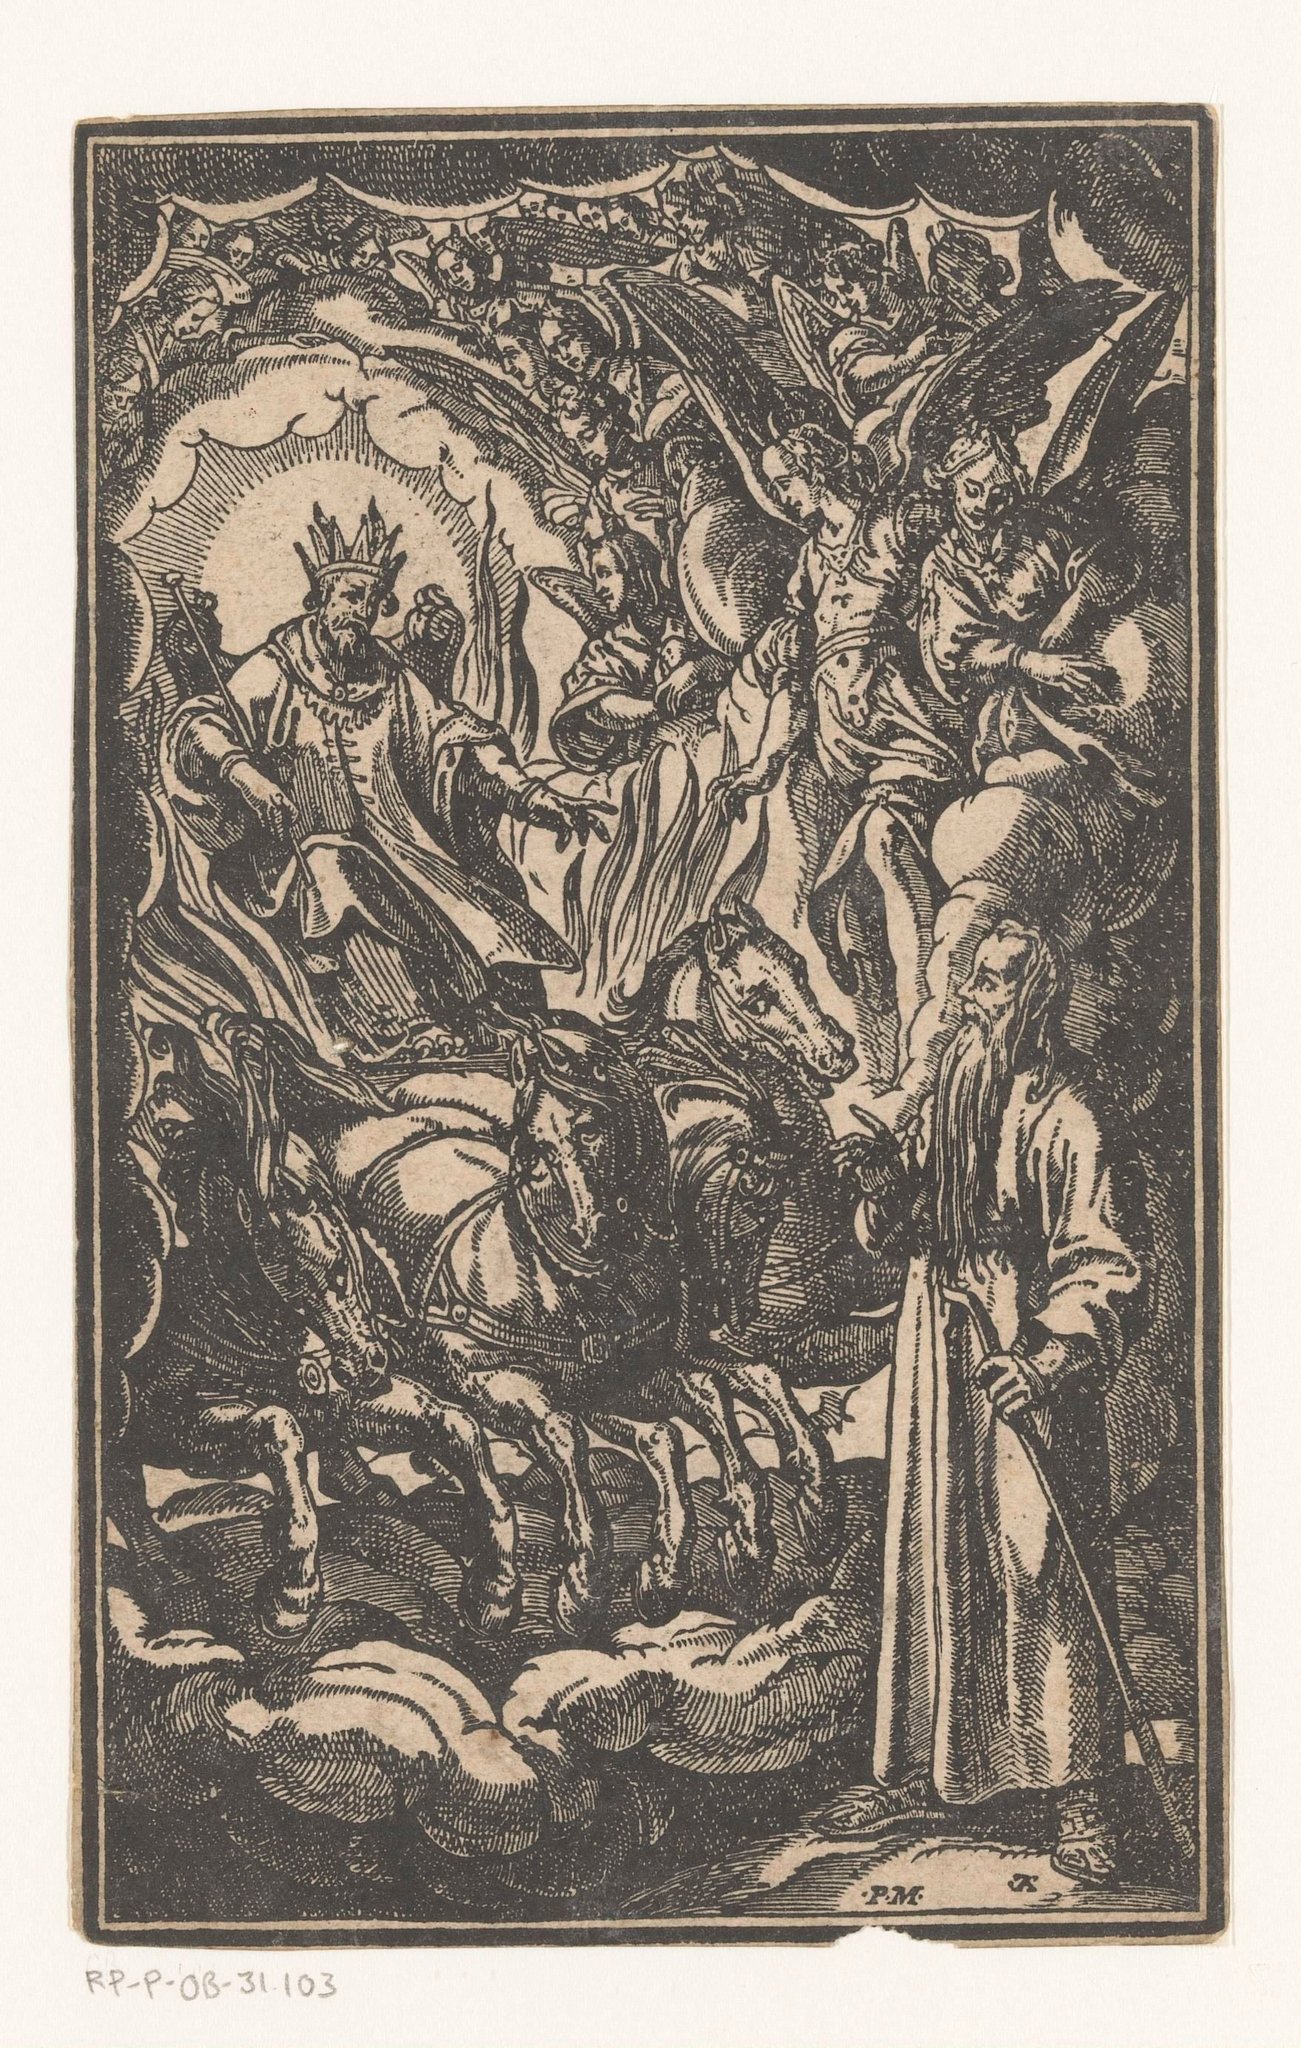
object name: print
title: Gekroonde heilige op een wagen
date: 1579-1622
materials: paper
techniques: woodcut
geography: italy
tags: chariot, triumphal car, saints, angels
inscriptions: collector's mark: Lugt 240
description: Een gekroonde mannelijke heilige, zittend op een wagen getrokken door paarden en omringd door engelen. Rechts op de voorgrond staat een bebaarde man met een stok.